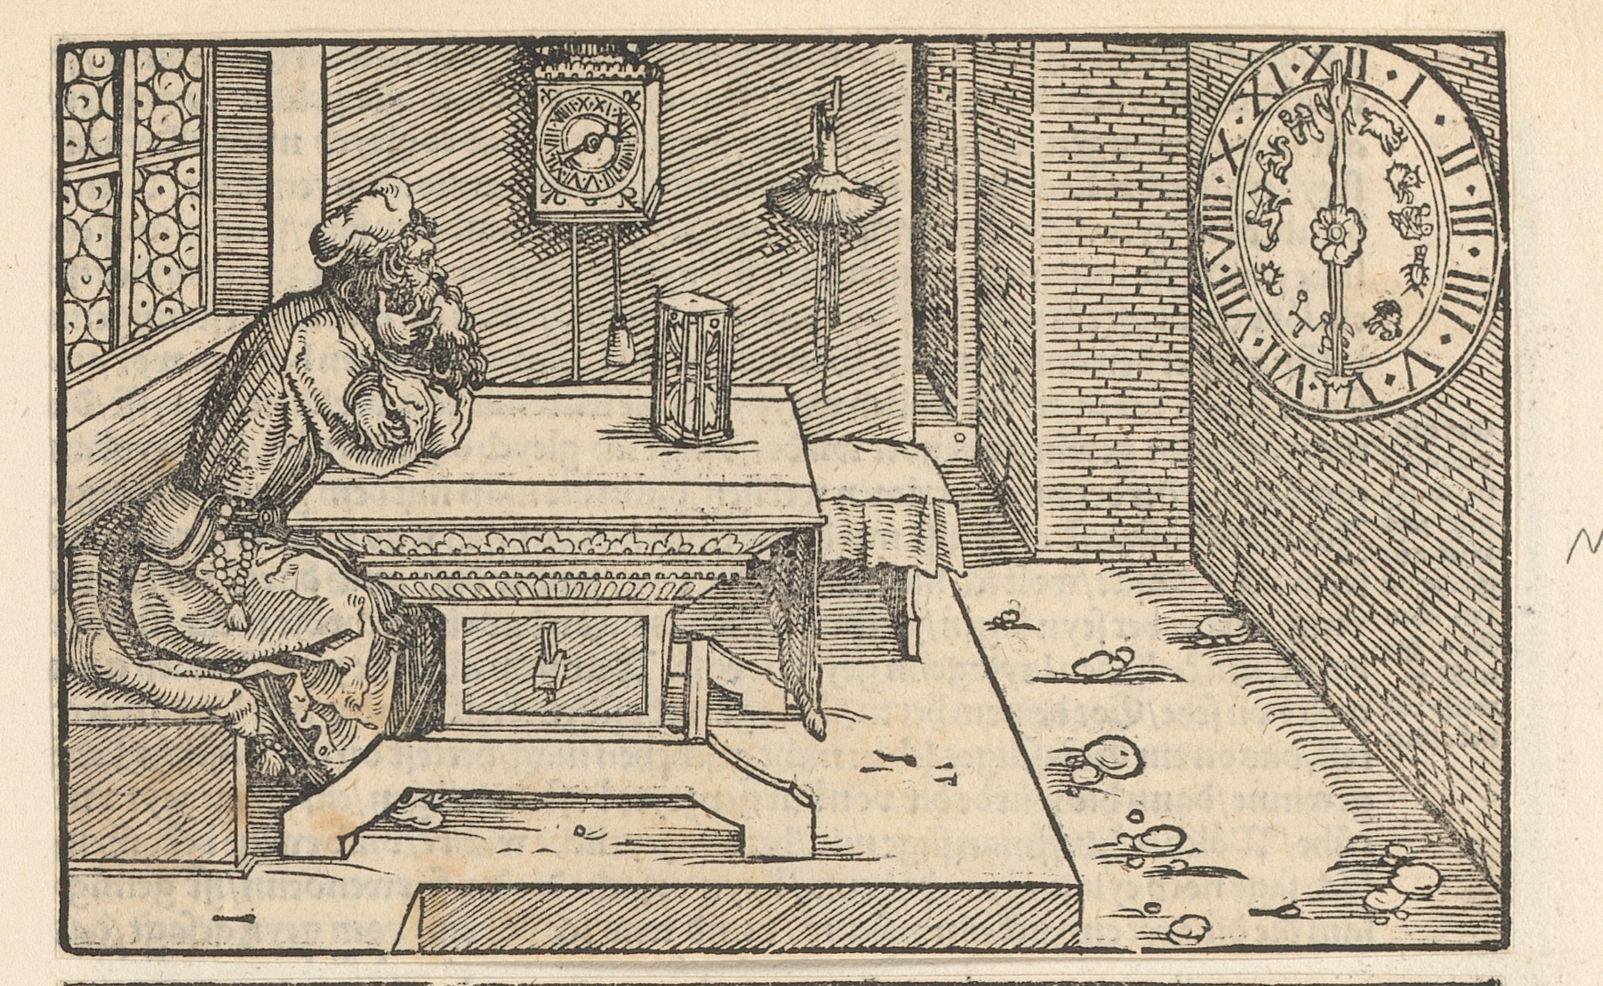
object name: print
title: Oude man kijkt met het hoofd in zijn handen naar een zandloper en wandklokken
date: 1514-1532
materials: paper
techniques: letterpress printing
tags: scenes symbolizing 'vanitas', clock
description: Deze prent is gebruikt in: Petrarca, Francesco. Von der Artzney bayder Glück, des guten und widerwertigen: unnd weß sich ain yeder inn Gelück und Unglück halten sol (...). Augsburg: Heinrich Steiner, 1532. Deze uitgave is ook bekend onder de titel 'Trostspiegel in Glück und Unglück'. Deze prent is ook gebruikt in: Cicero, Marcus Tulius. Officia M.T.C. Ein Buch so Marcus Tullius Cicero der Römer zu seynem (...). [Vertaald uit het Latijn door] Johann von Schwarzenberg. Augsburg: Heinrich Steiner, 1531.